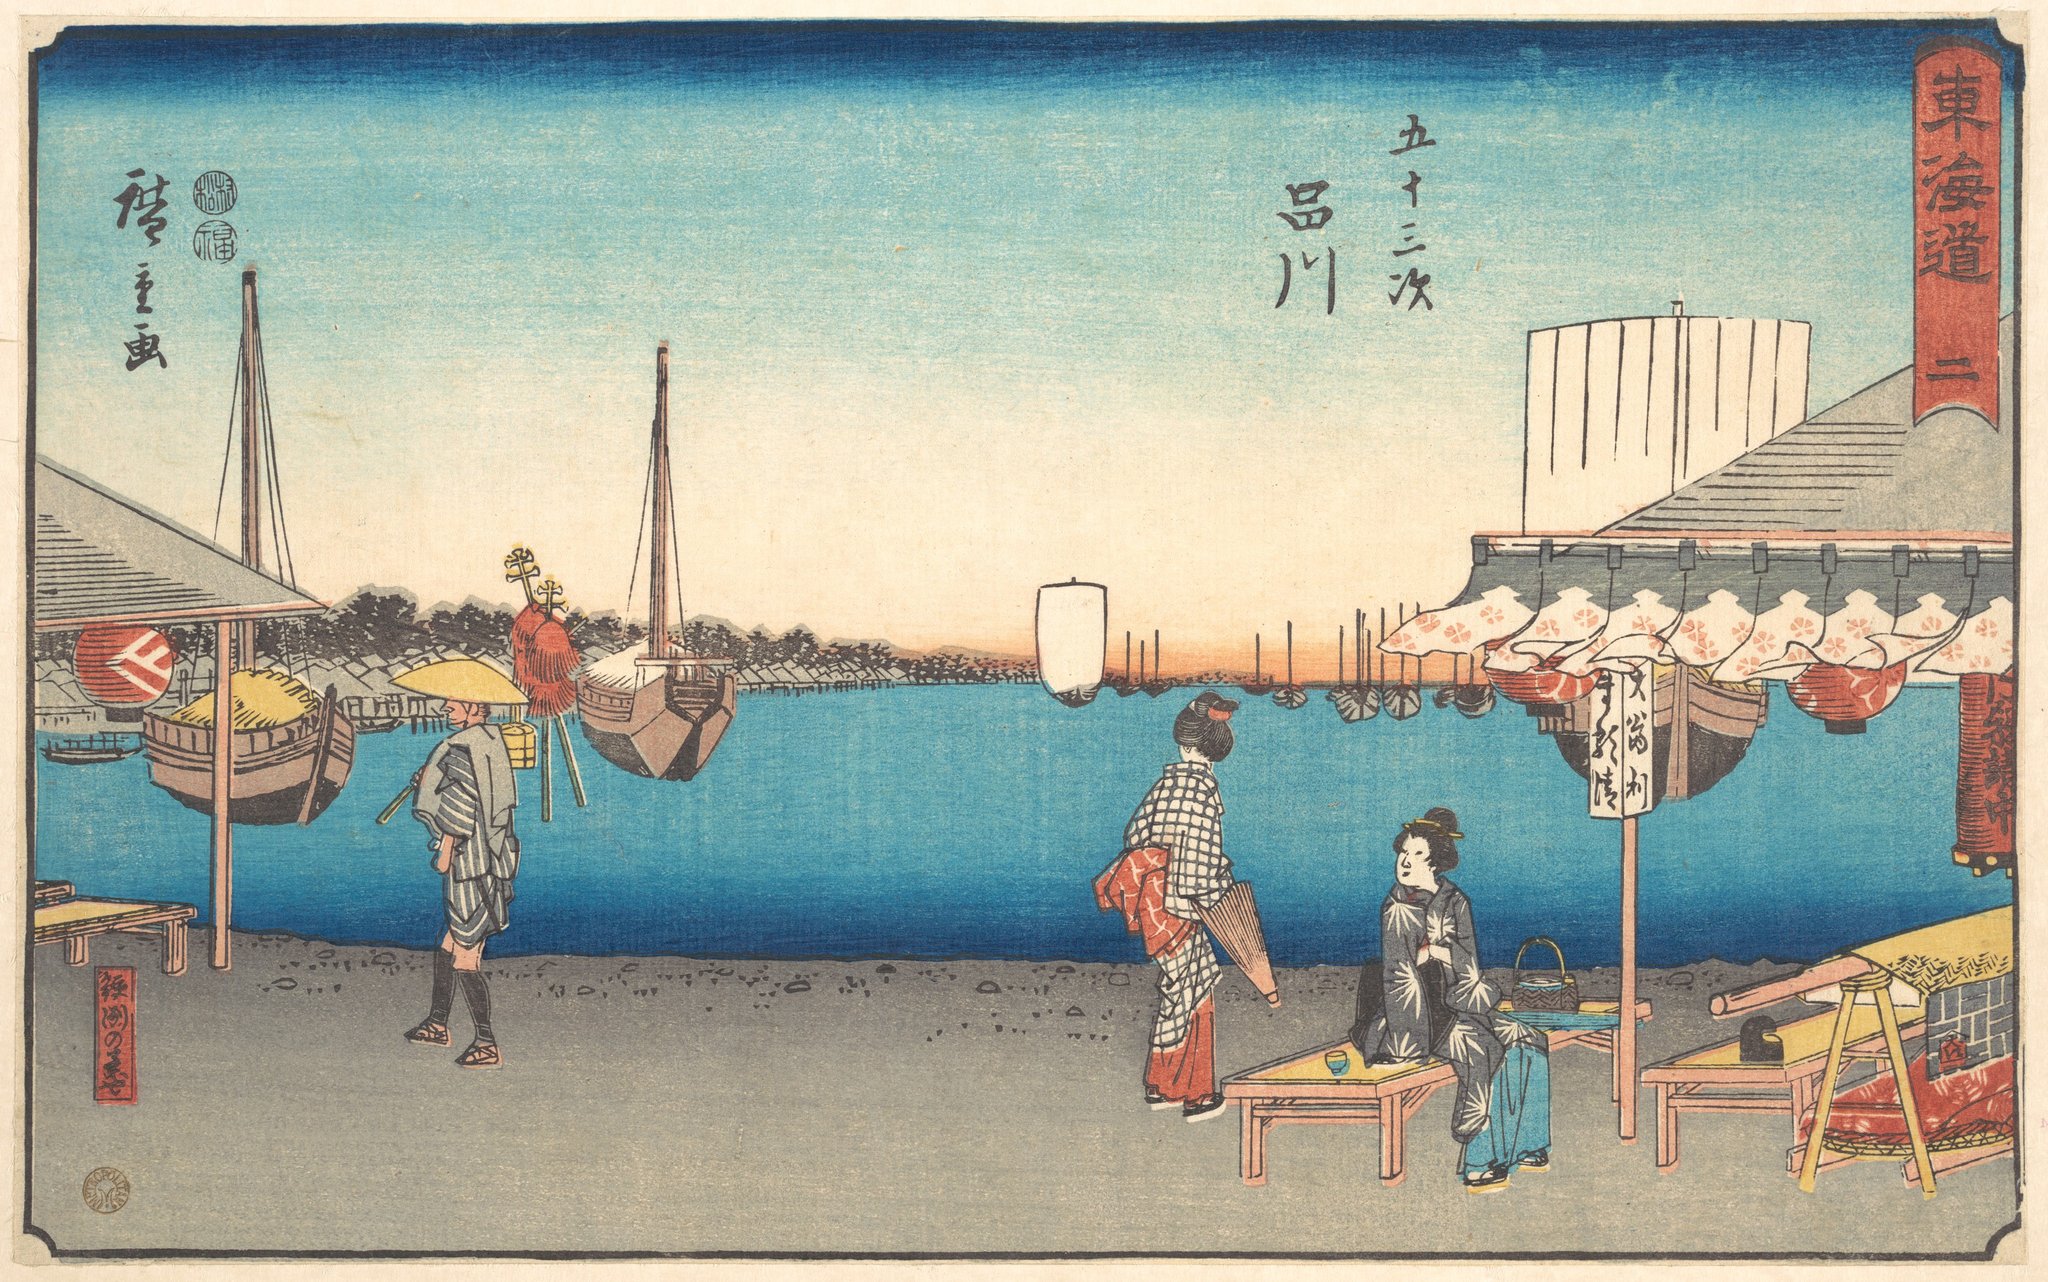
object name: print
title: Shinagawa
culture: japanese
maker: utagawa hiroshige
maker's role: artist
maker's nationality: japanese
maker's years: 1797-1858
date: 1840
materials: ink, paper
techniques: woodblock print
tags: men,women,boats,tea houses